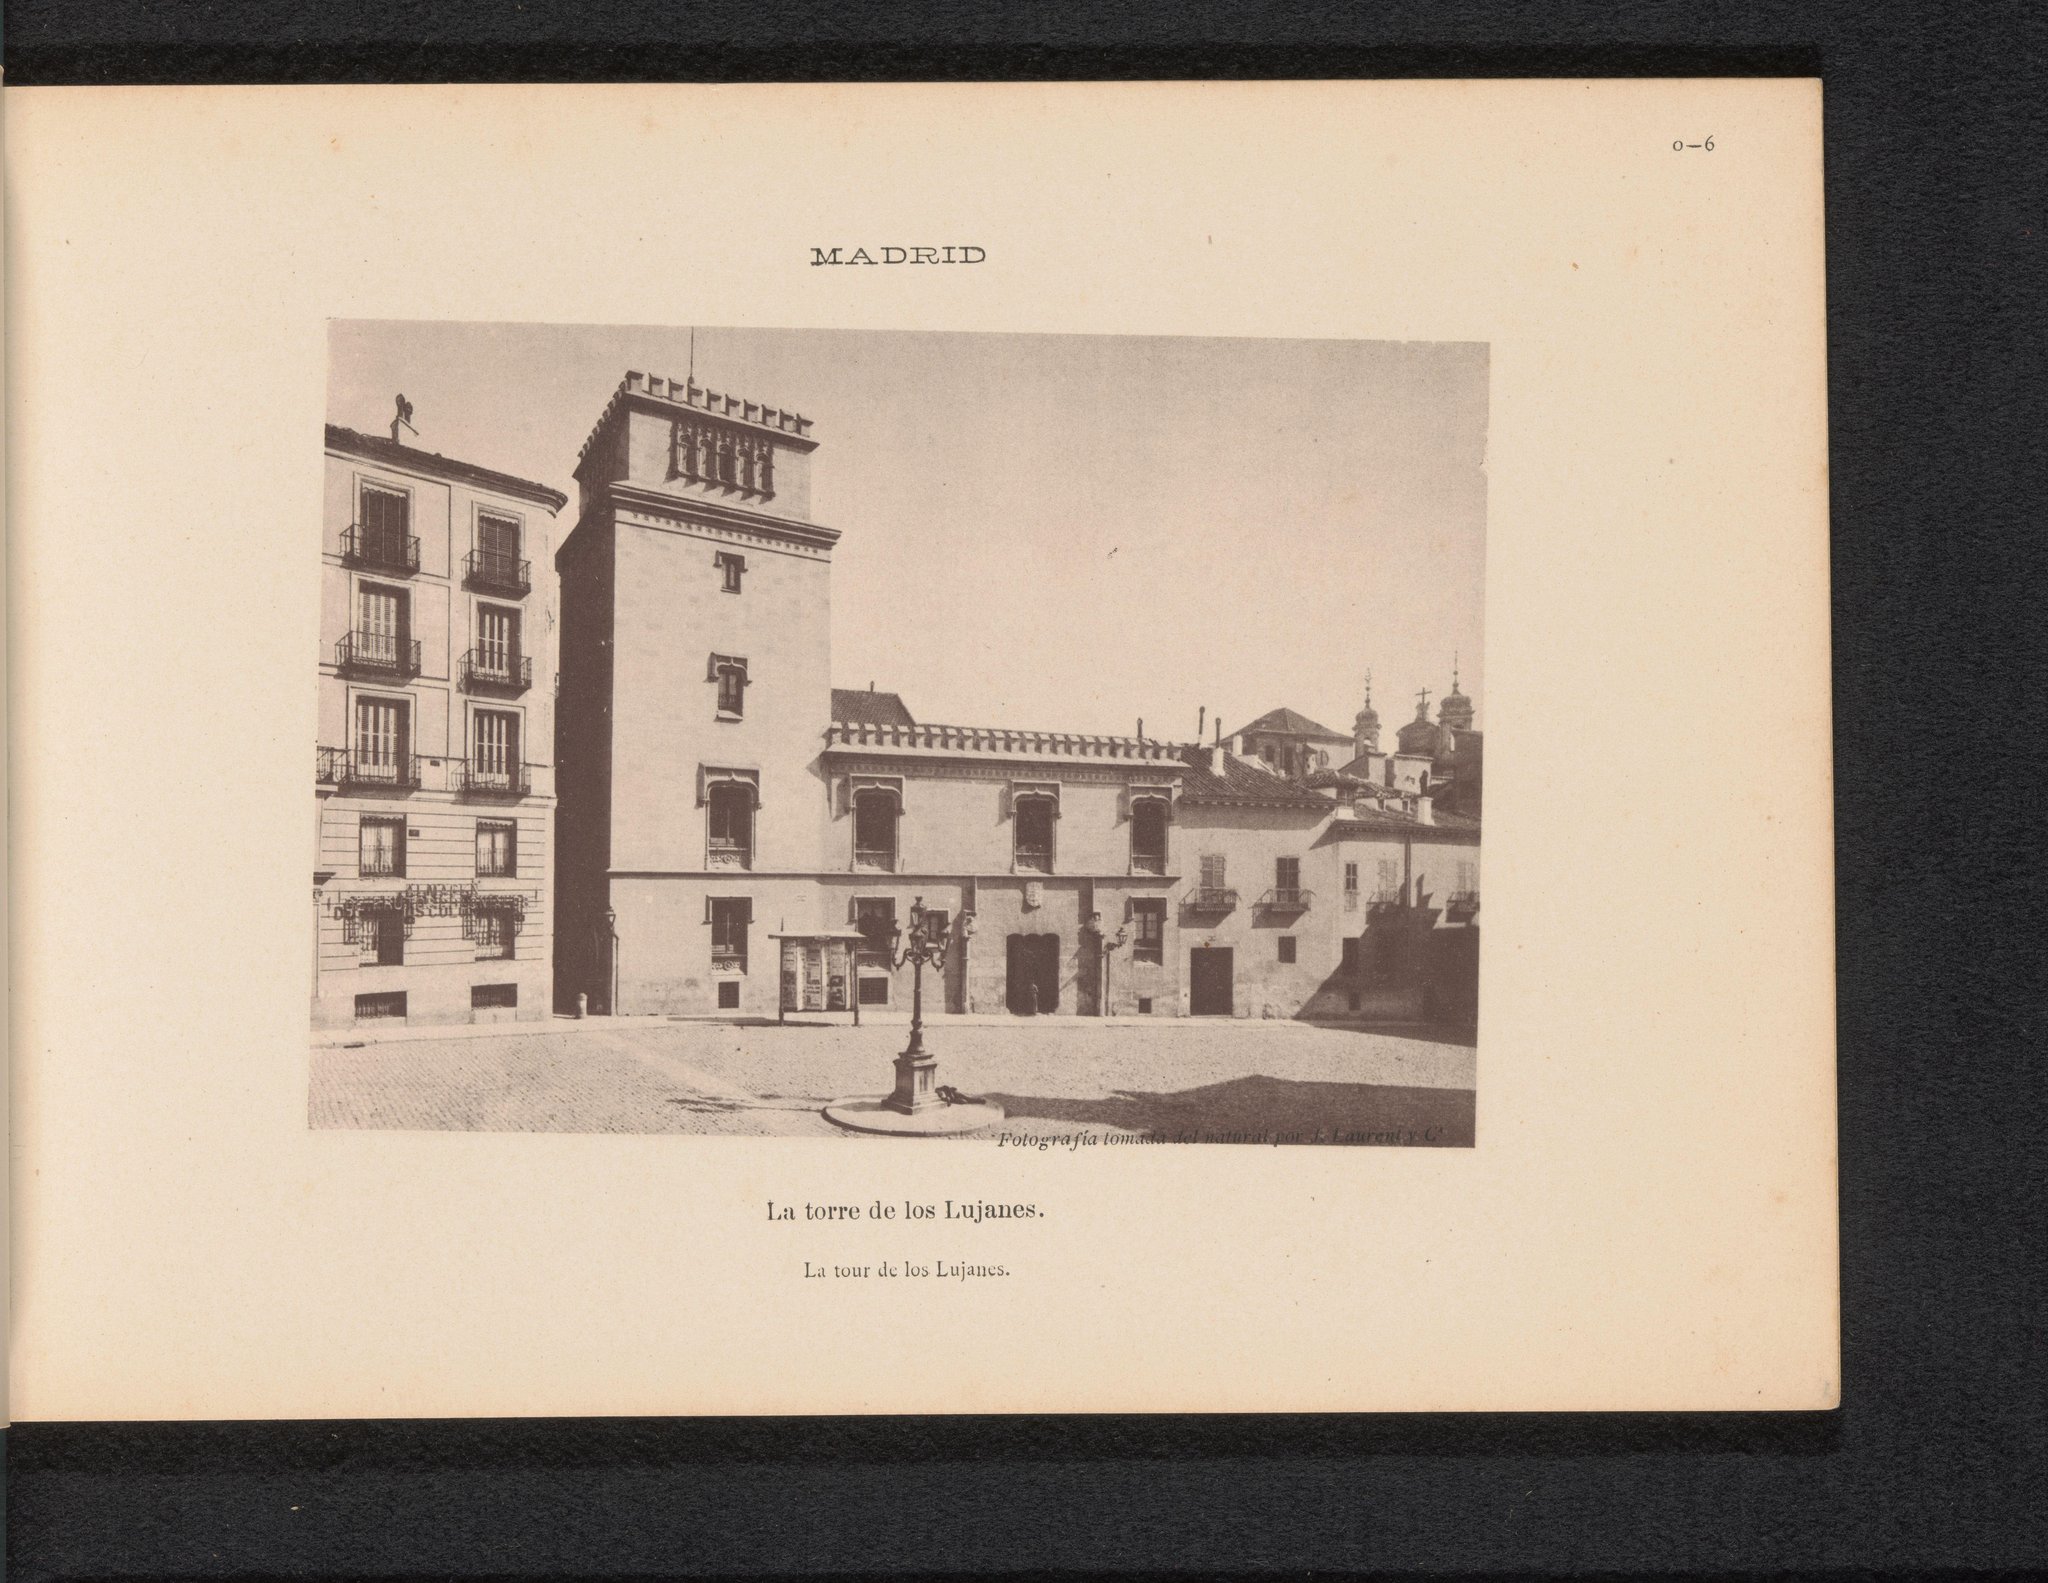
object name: page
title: Madrid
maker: juan laurent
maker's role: publisher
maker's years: 1816-1896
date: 1880-1890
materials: paper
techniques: photograph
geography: madrid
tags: tower, clock tower ~ monumental adornment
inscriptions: number: ‘0-6’